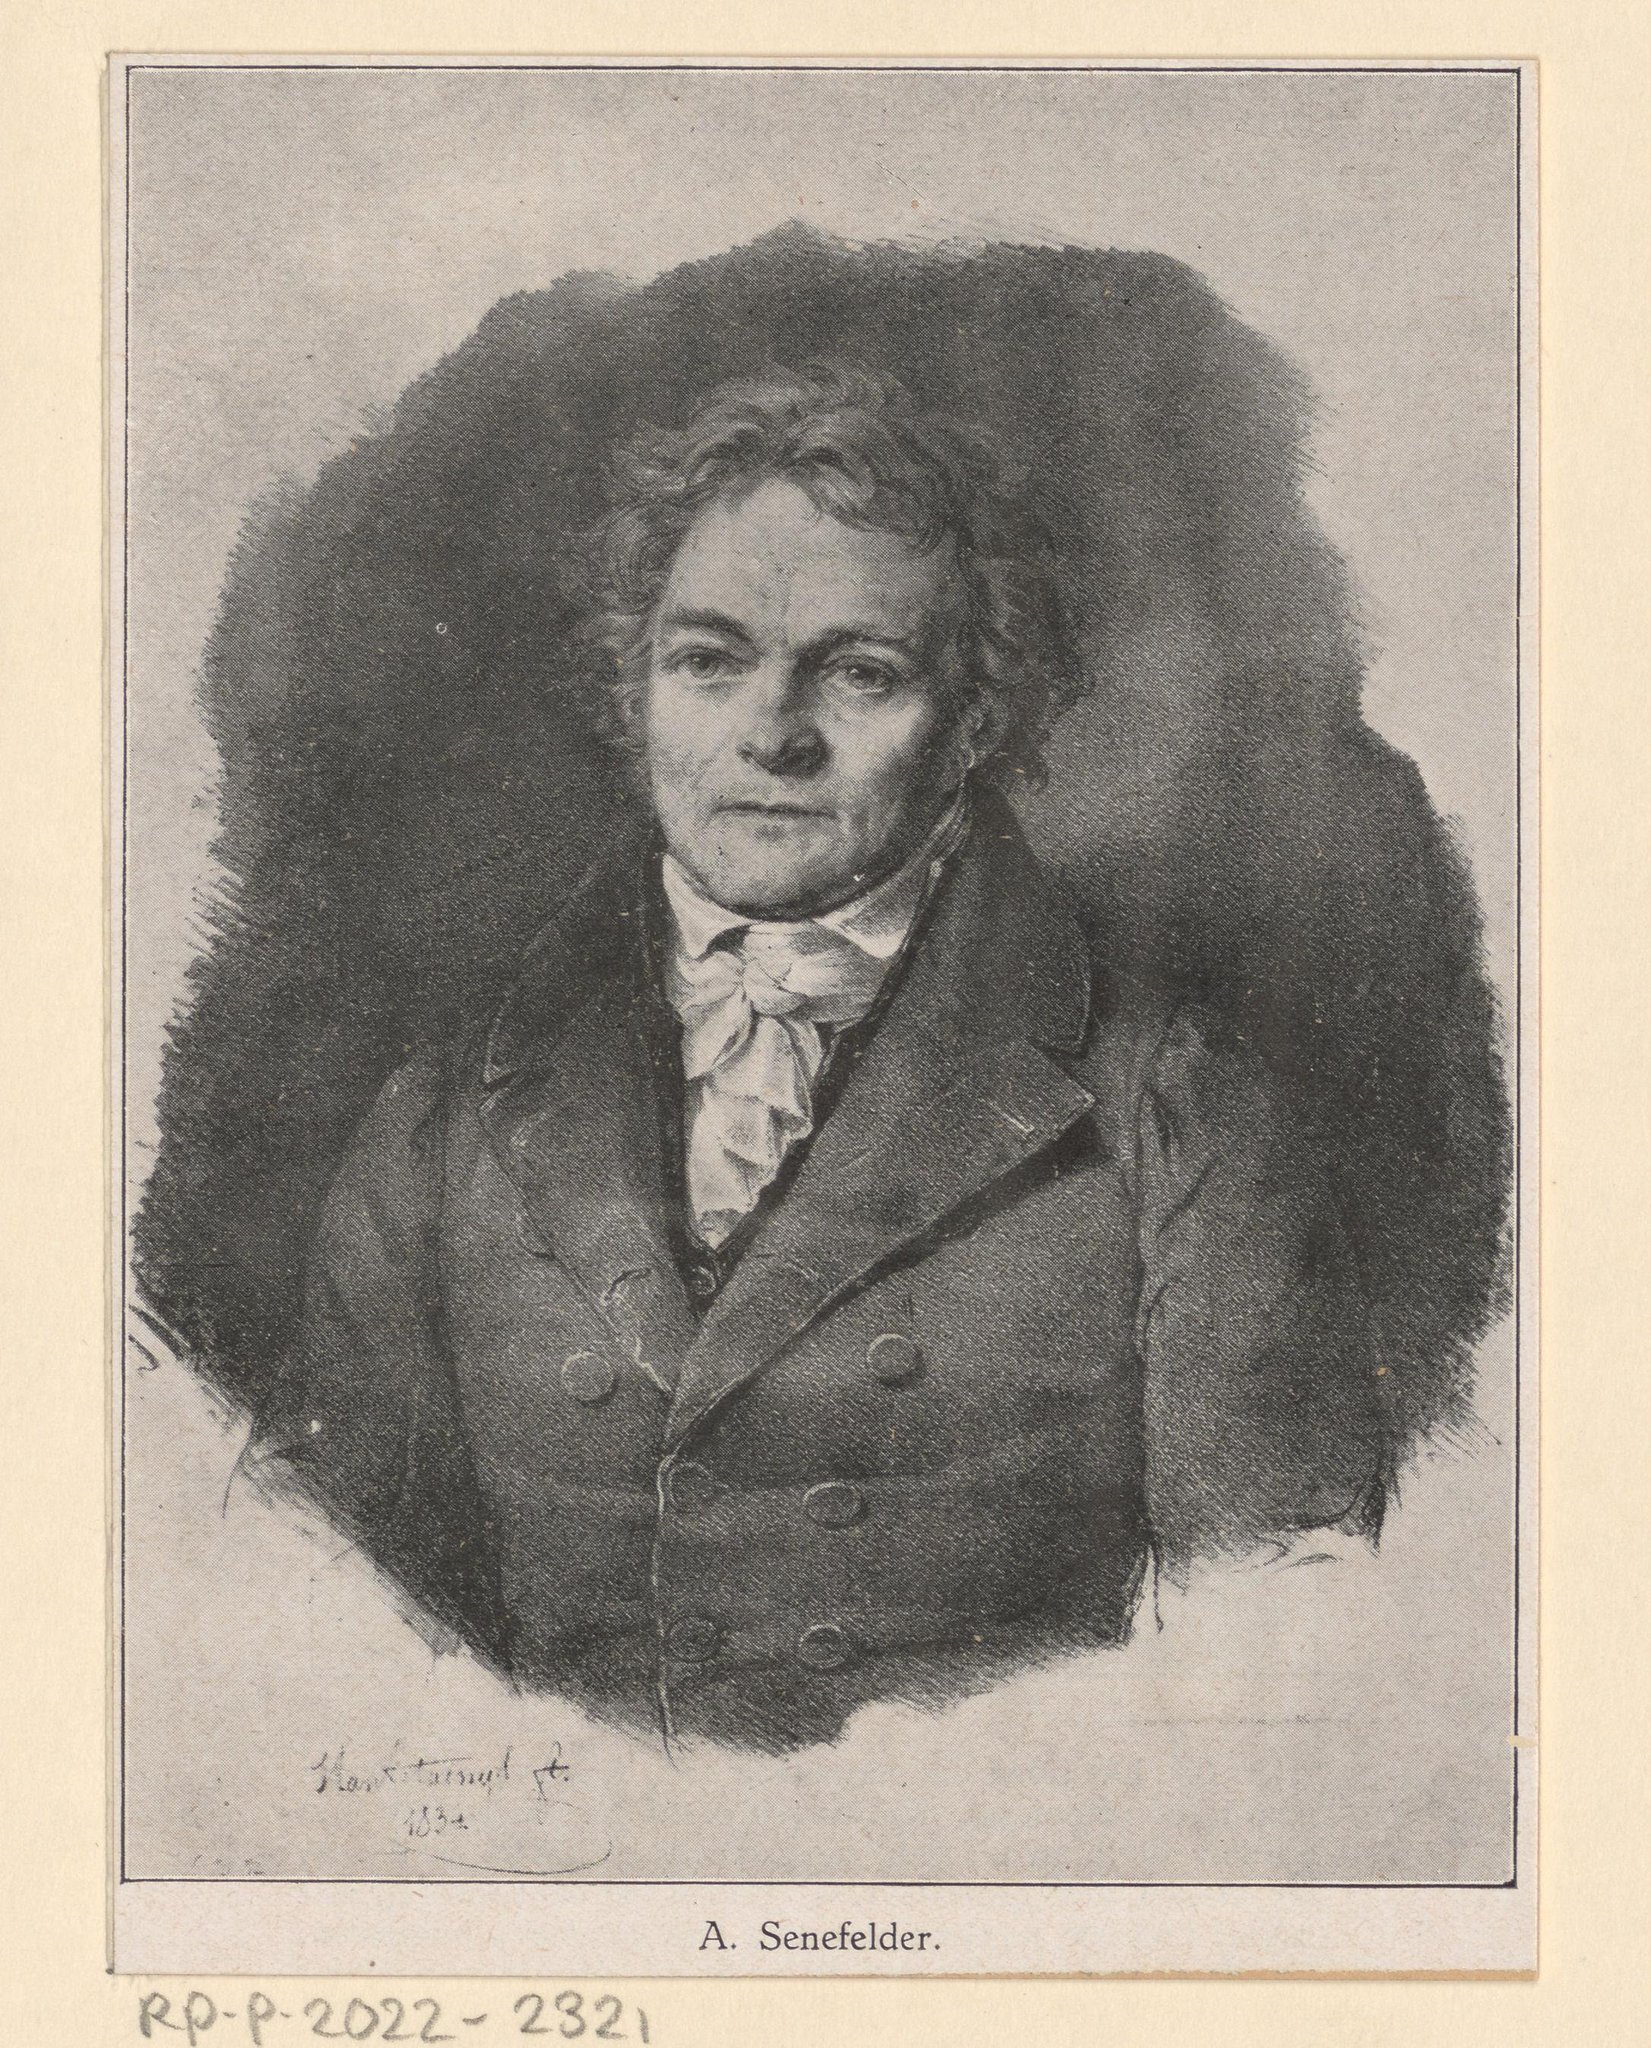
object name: photomechanical print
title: Portret van Alois Senefelder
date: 1882-1970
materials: paper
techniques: autotype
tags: prague, print maker, printer, alois senefelder, historical persons, portrait, self-portrait of graphic artist, invention, discovery ~ science and technology